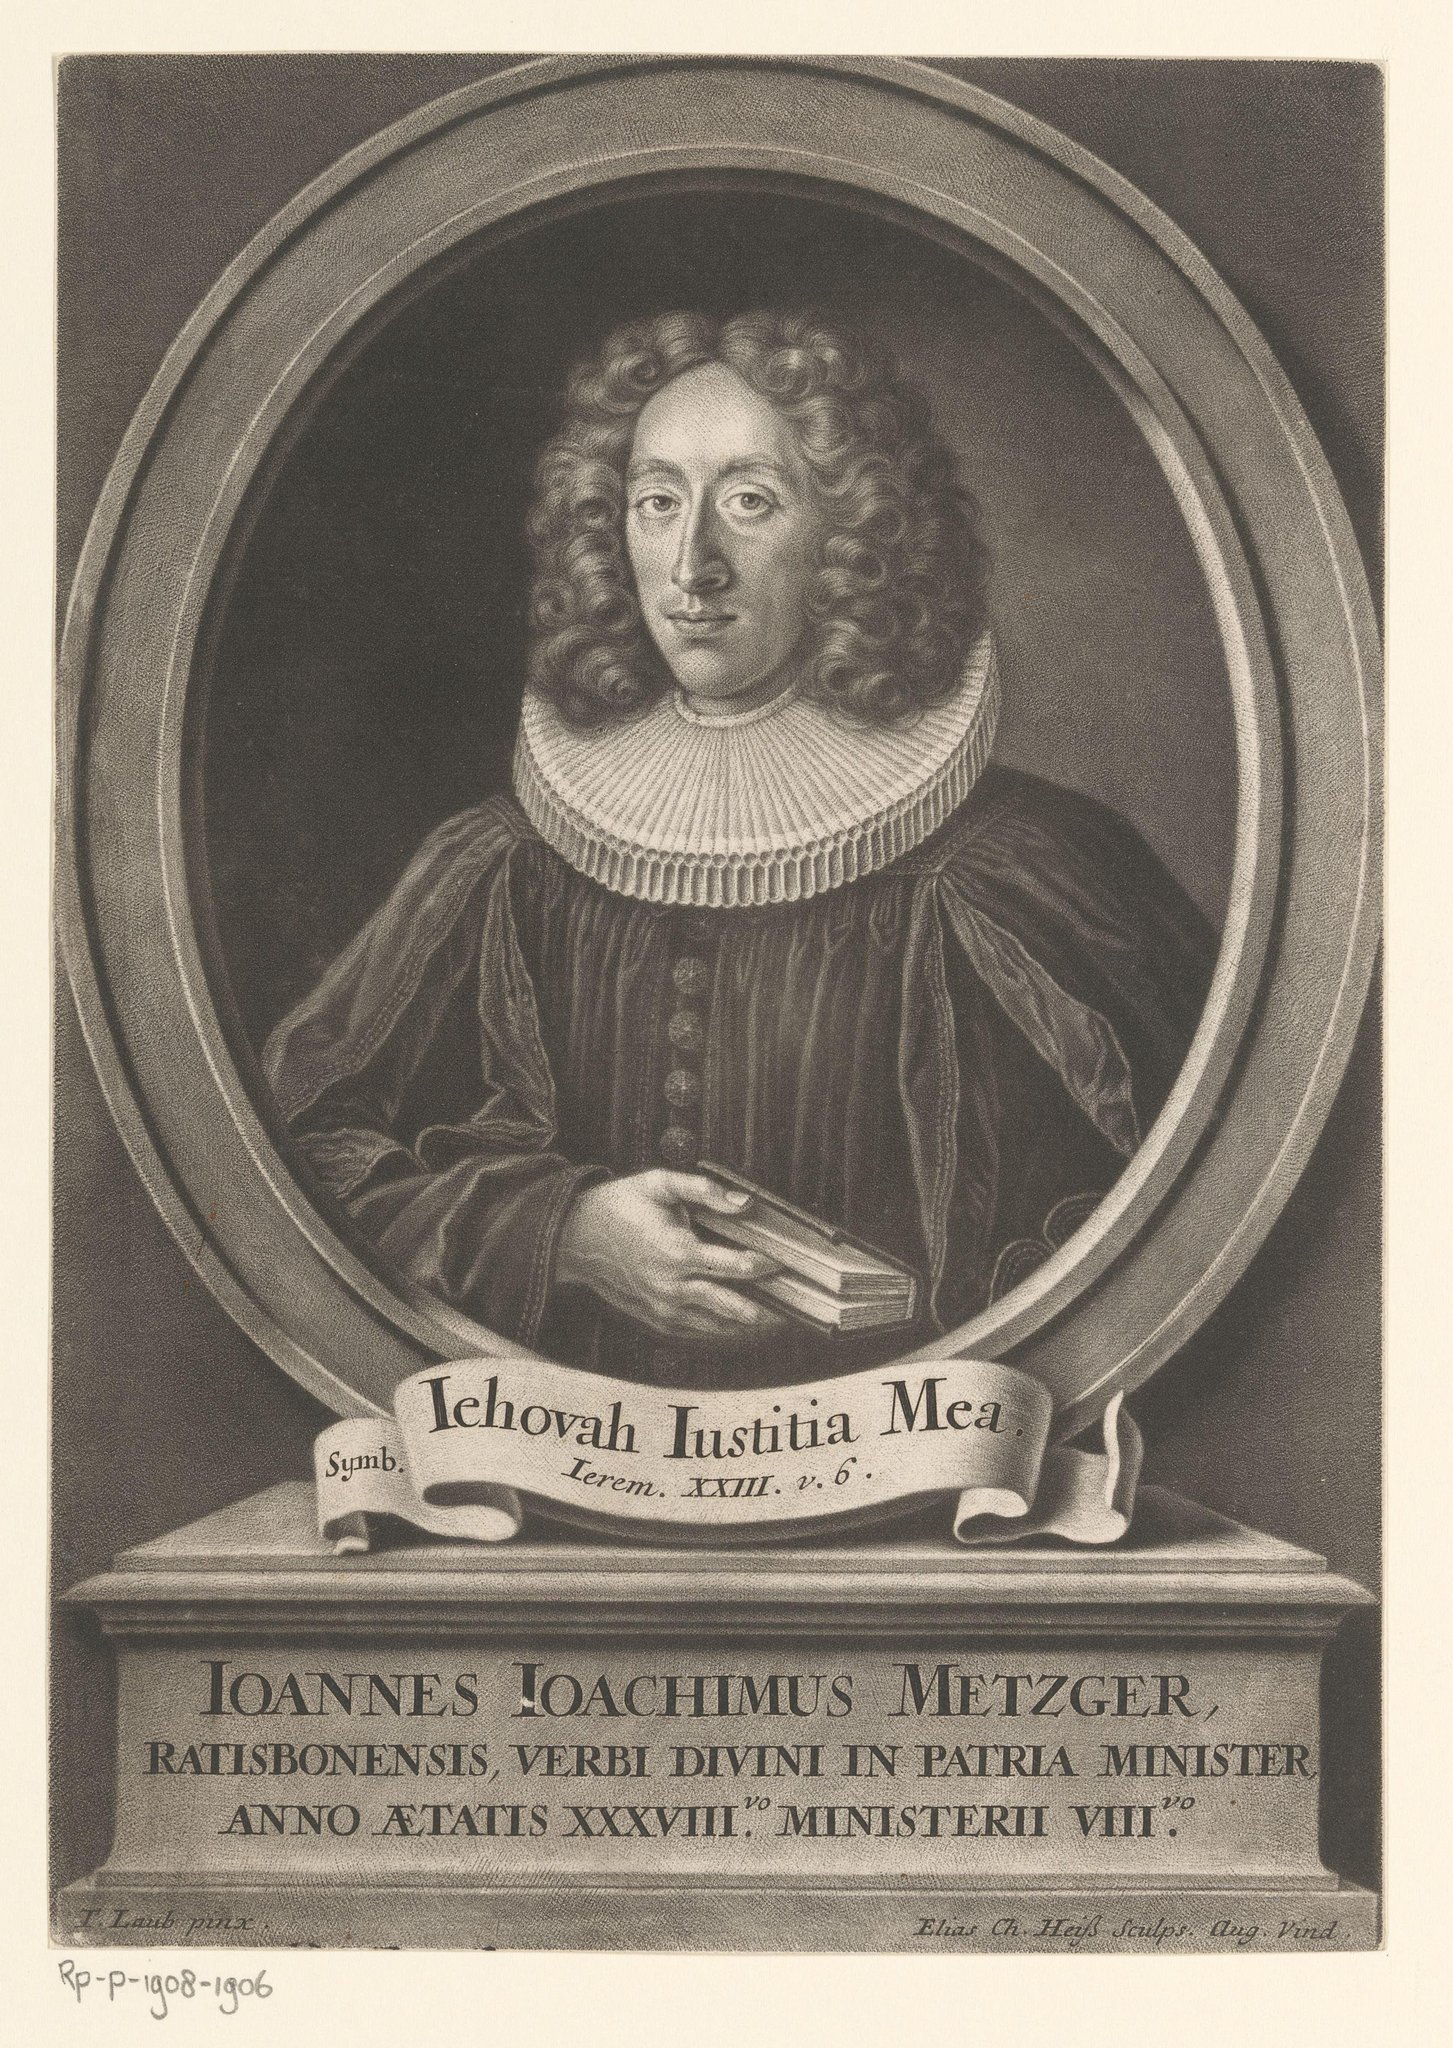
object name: print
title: Portret van Johann Joachim Metzger op 38-jarige leeftijd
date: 1711-1712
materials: paper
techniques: mezzotint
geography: augsburg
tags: historical persons, book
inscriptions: collector's mark: Lugt 2228